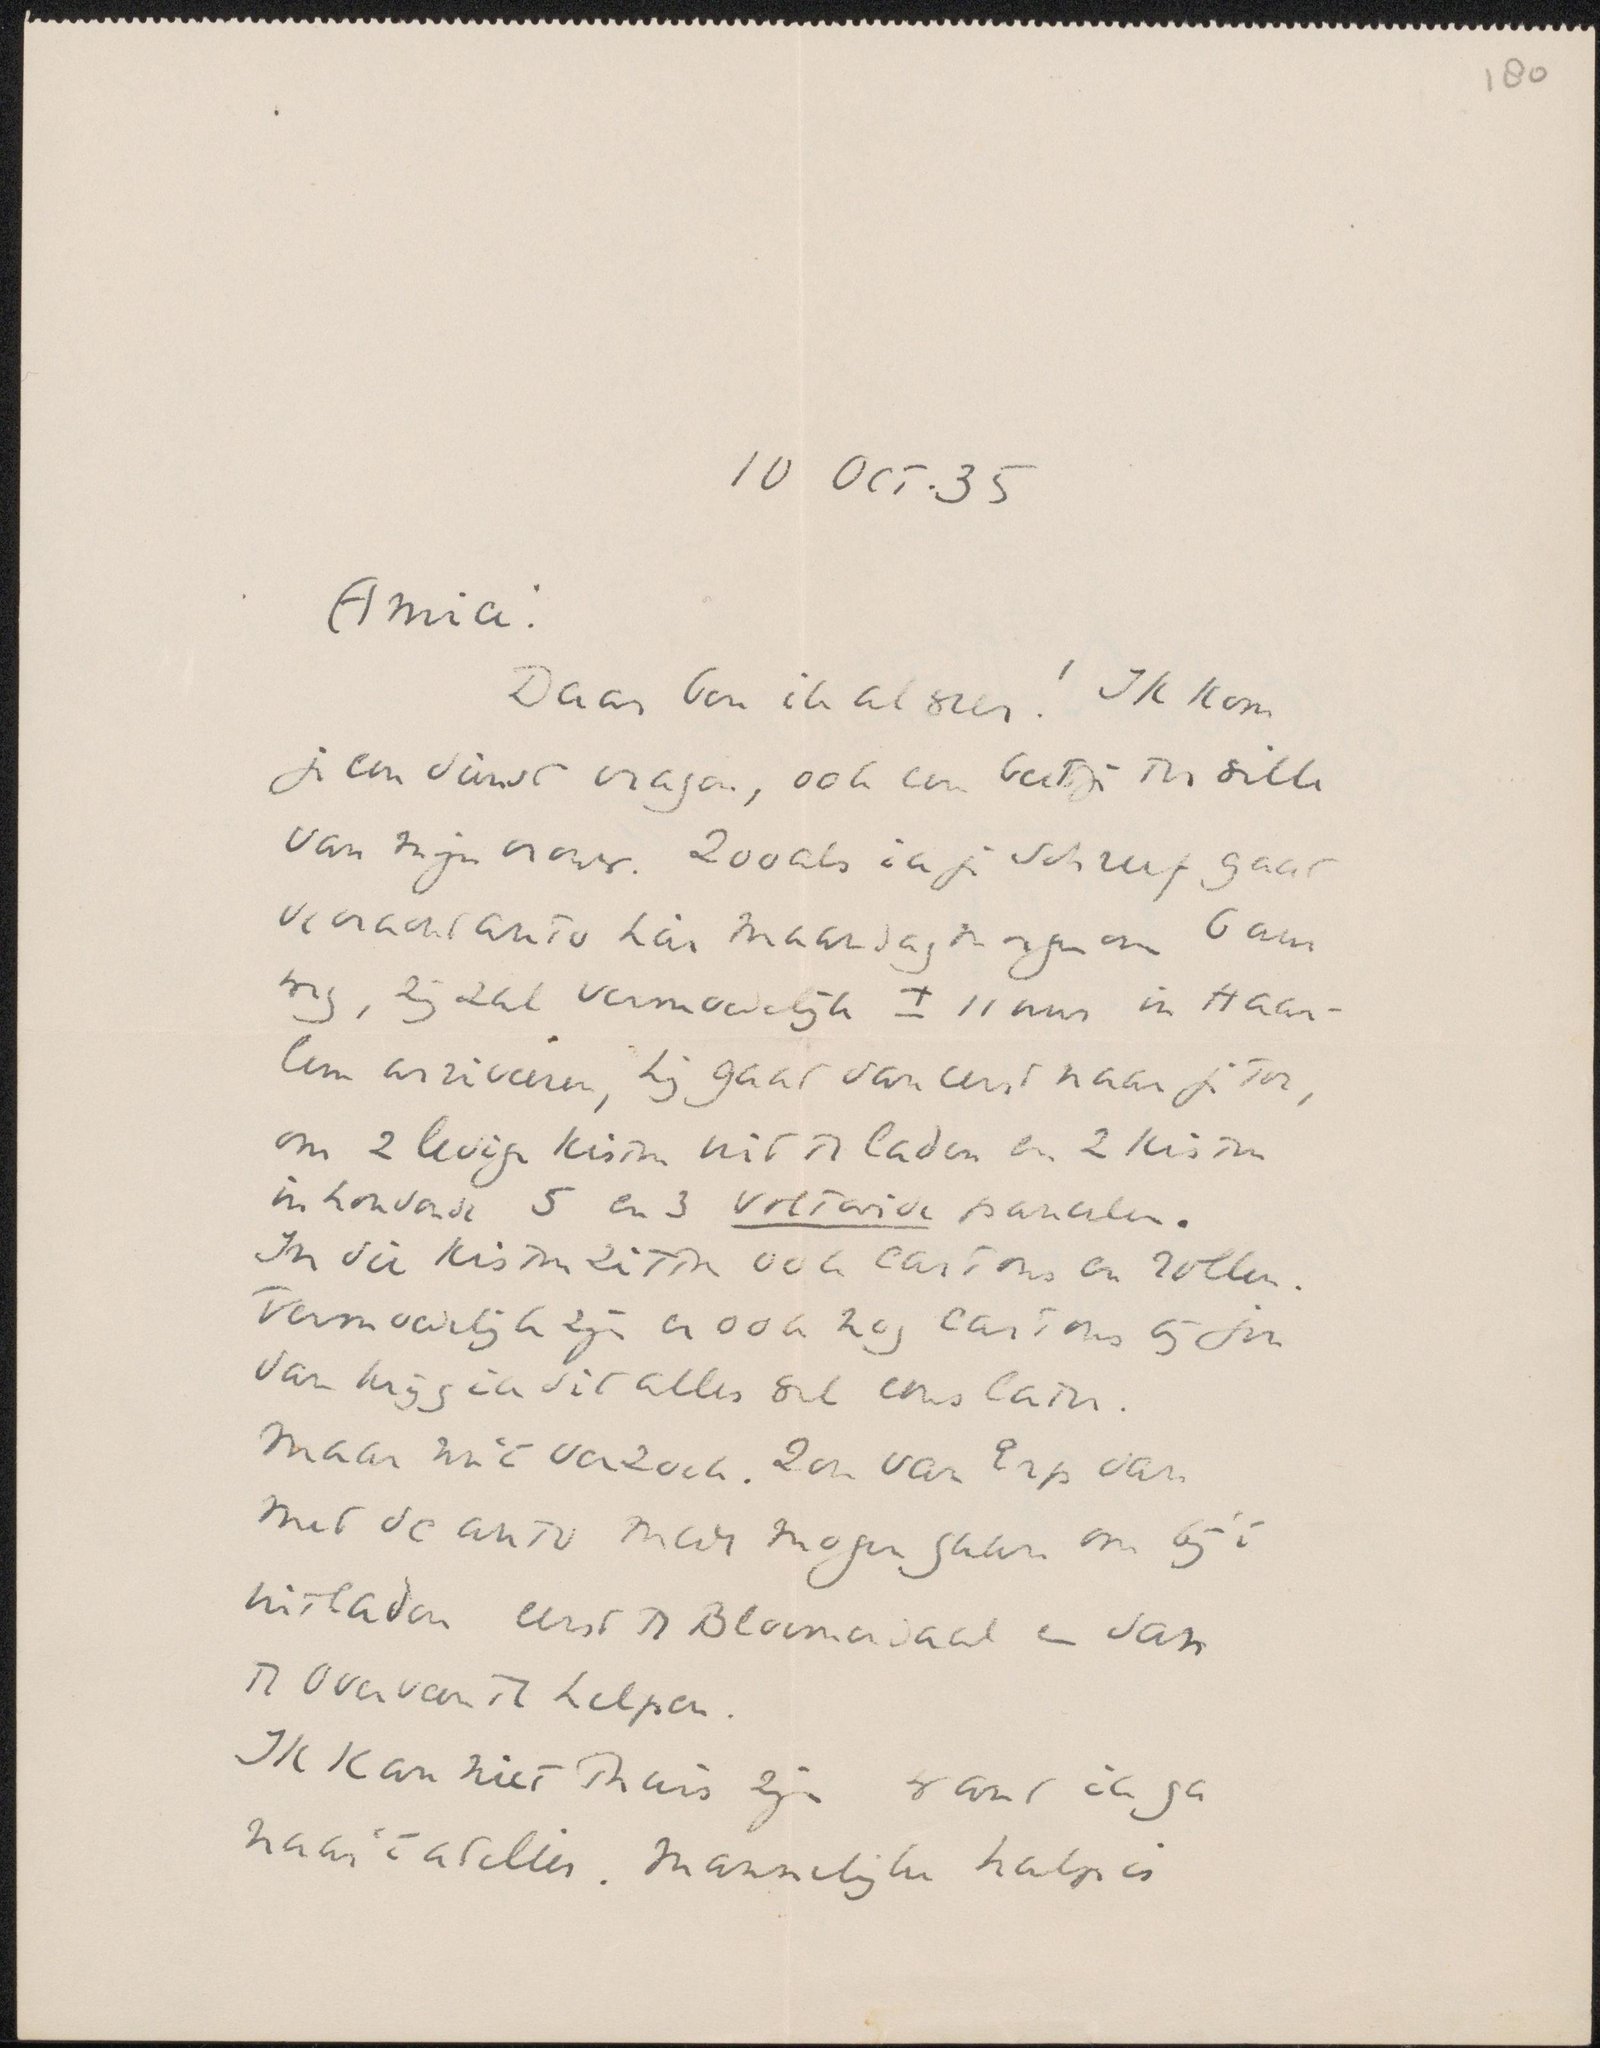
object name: letter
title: Brief aan Willem Bogtman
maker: richard nicolaüs roland holst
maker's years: 1868-1938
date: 1935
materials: ink, paper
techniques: pen, writing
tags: haarlem, willem bogtman, applied arts, arts and crafts; industrial design, painting (including book-illumination, miniature-painting), workshop, studio of the artist (in general)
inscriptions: watermark